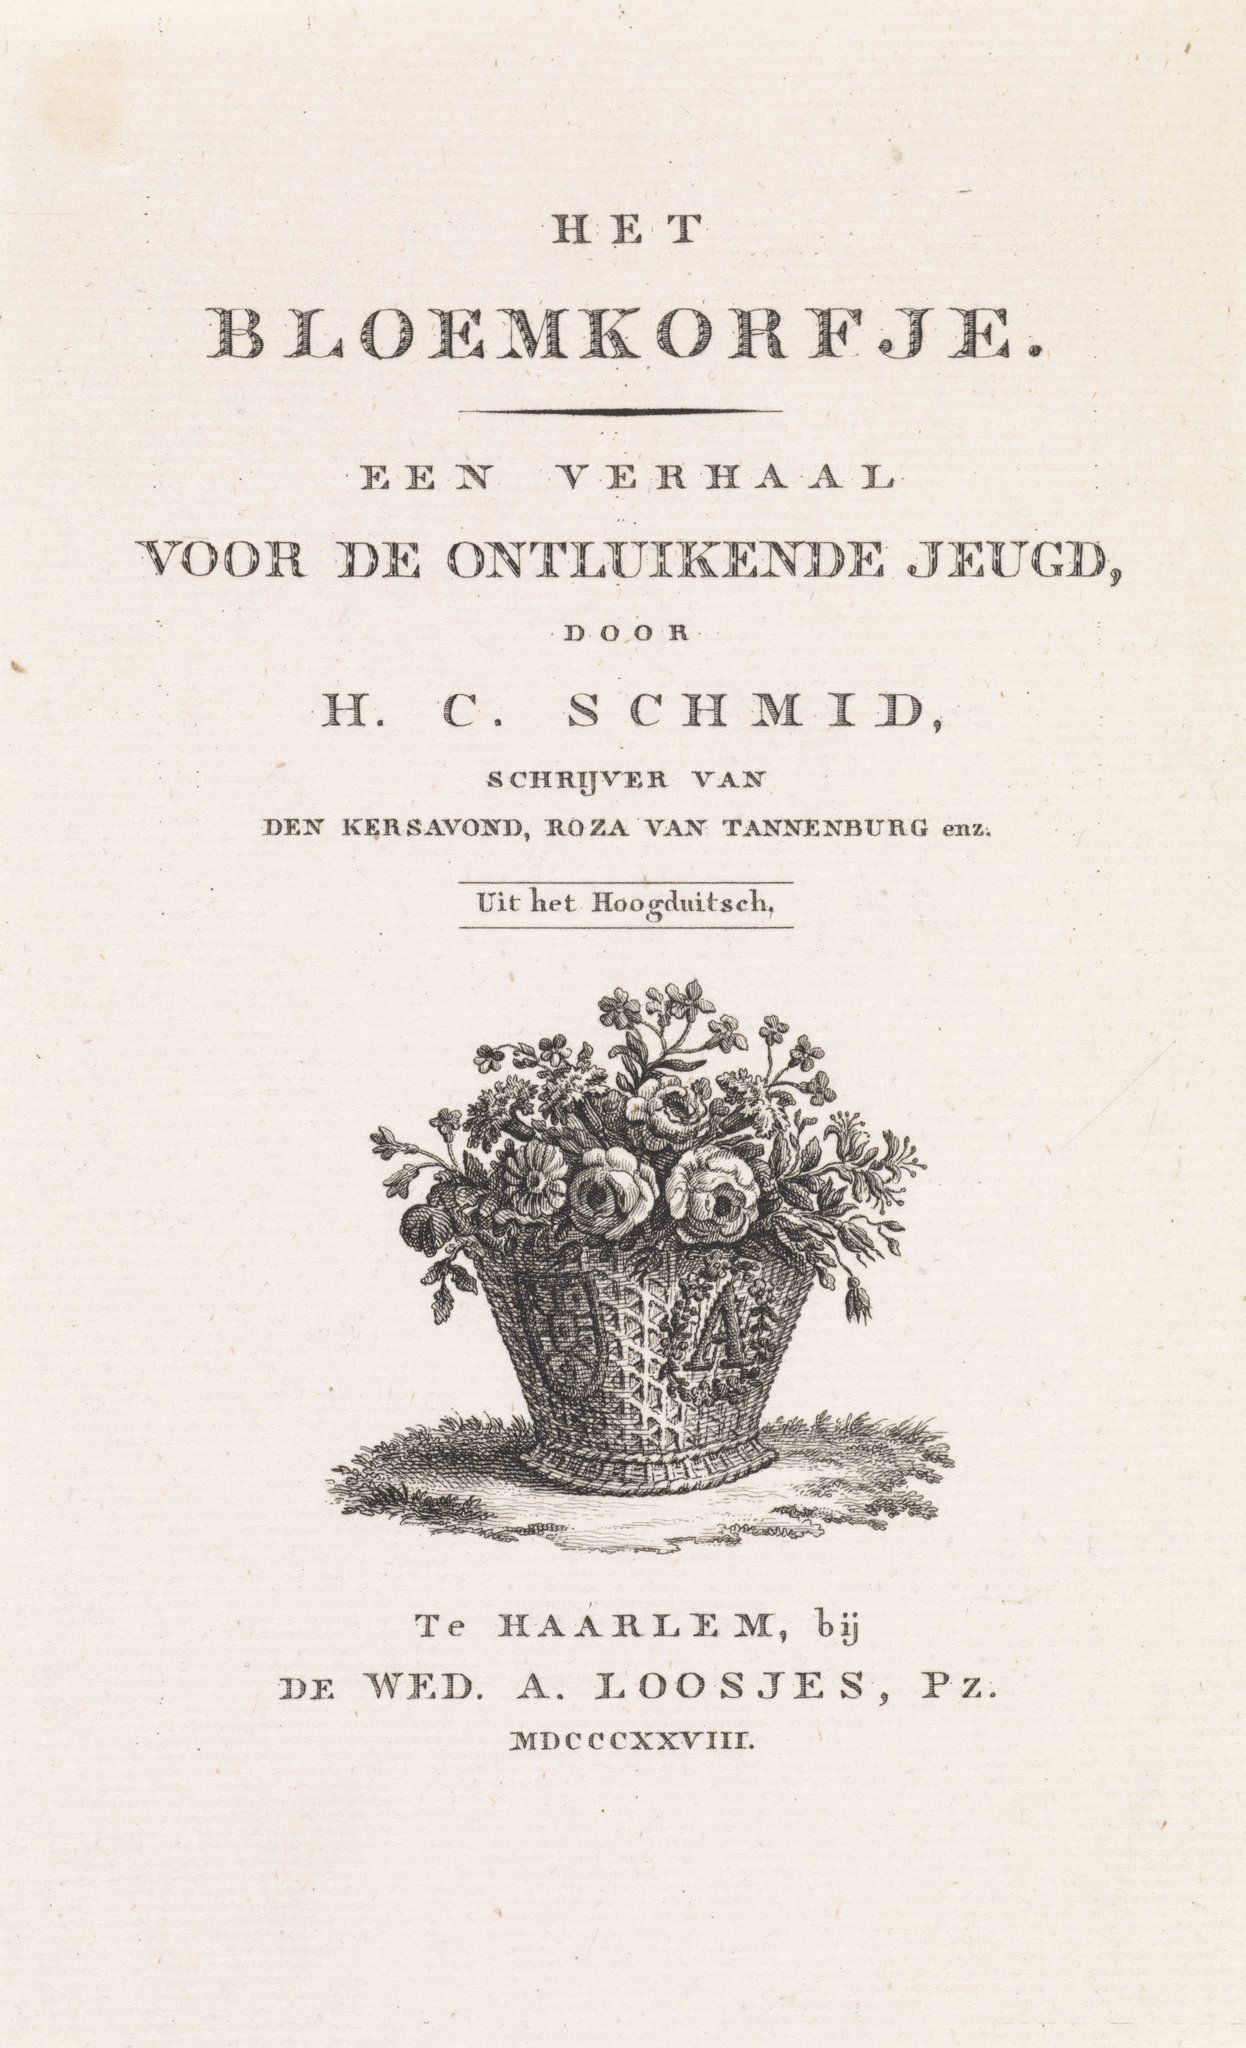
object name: titelblad, titelpagina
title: Titelpagina voor: H.C. von Schmid, Het Bloemkorfje, 1828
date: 1828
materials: paper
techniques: engraving, etching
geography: haarlem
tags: garden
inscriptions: collector's mark: Lugt 2228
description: Titelpagina voor: Schmid, H.C. von. Het bloemkorfje: een verhaal voor de ontluikende jeugd. Haarlem: Haarlem: Weduwe Adriaan Loosjes Pz., 1828.